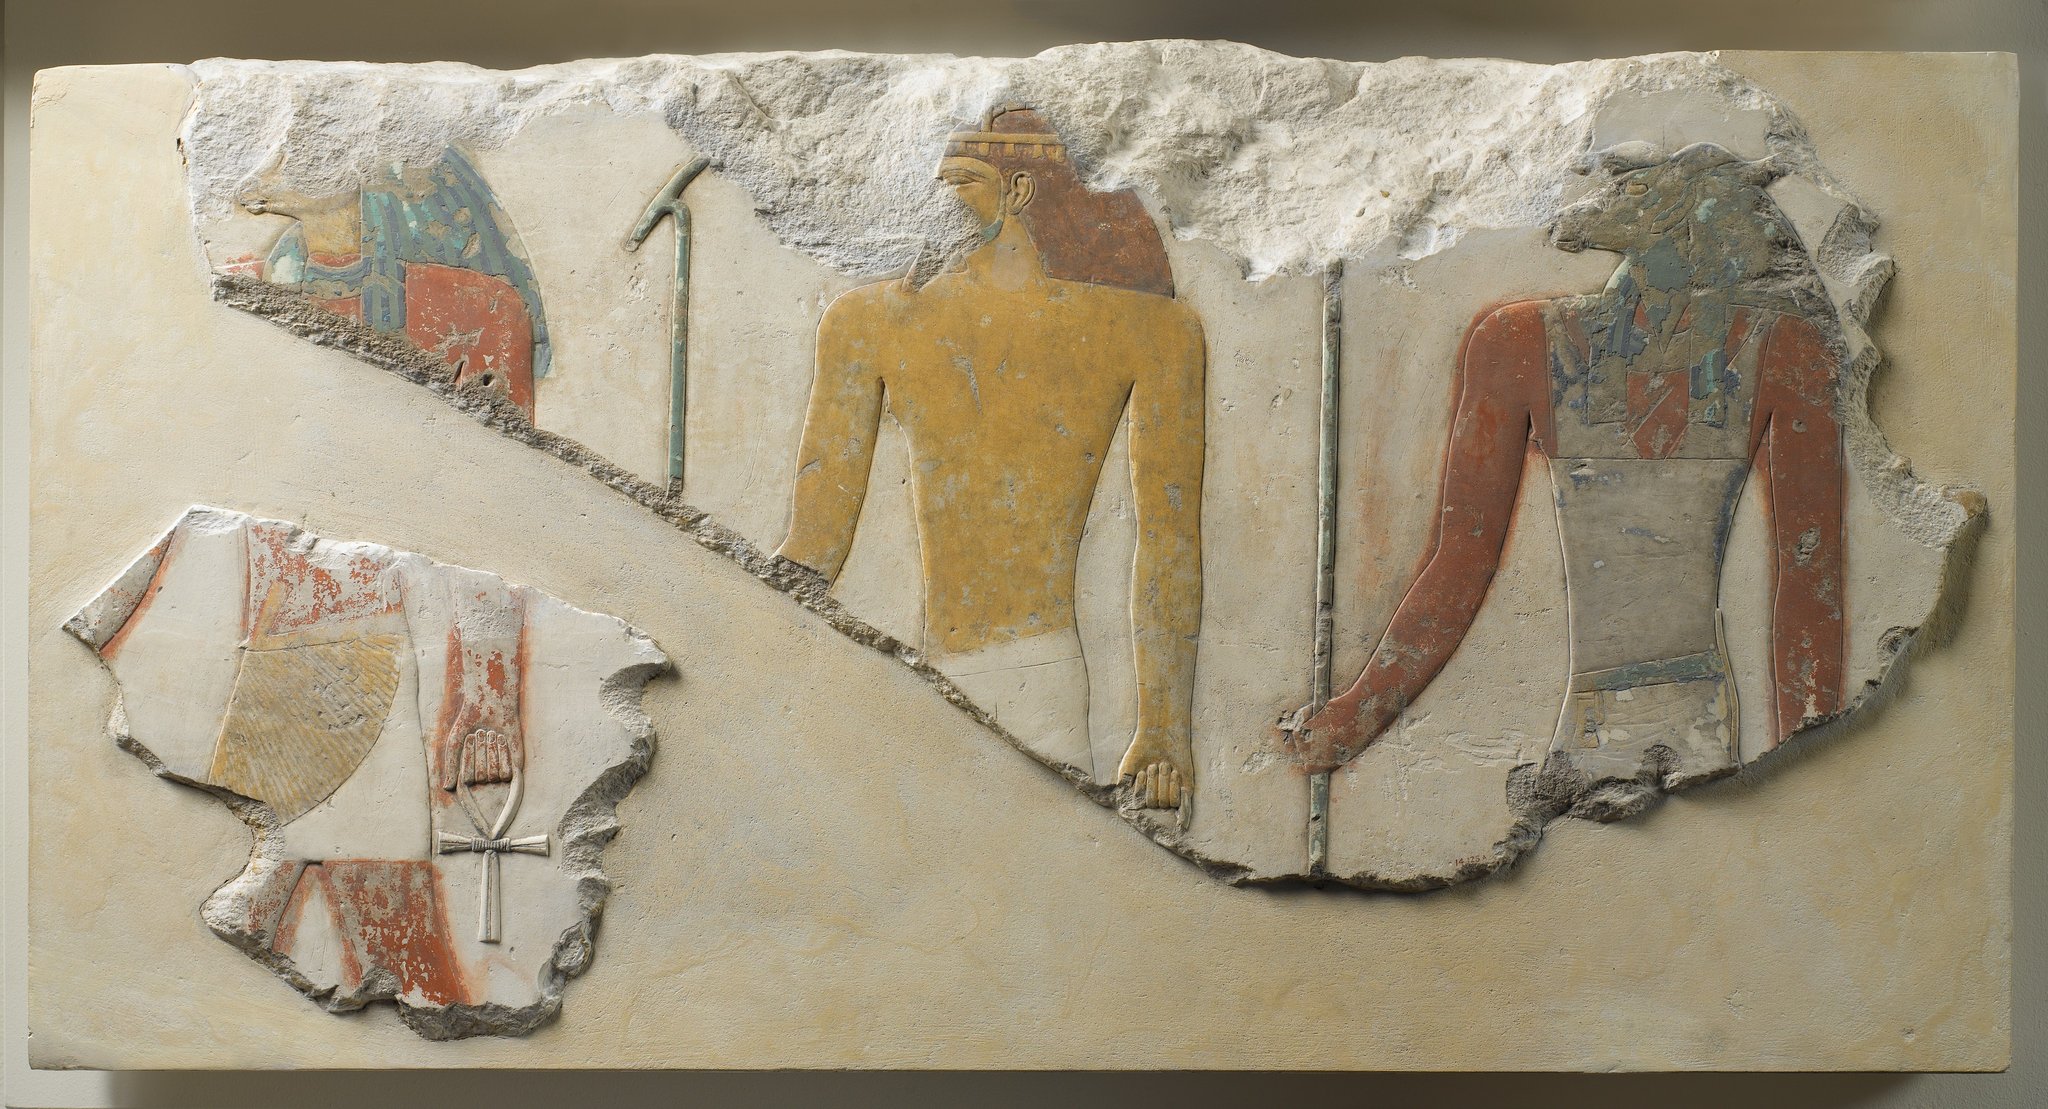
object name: relief, three god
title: Procession of Deities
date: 1887-1878 BCE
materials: limestone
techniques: painting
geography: egypt